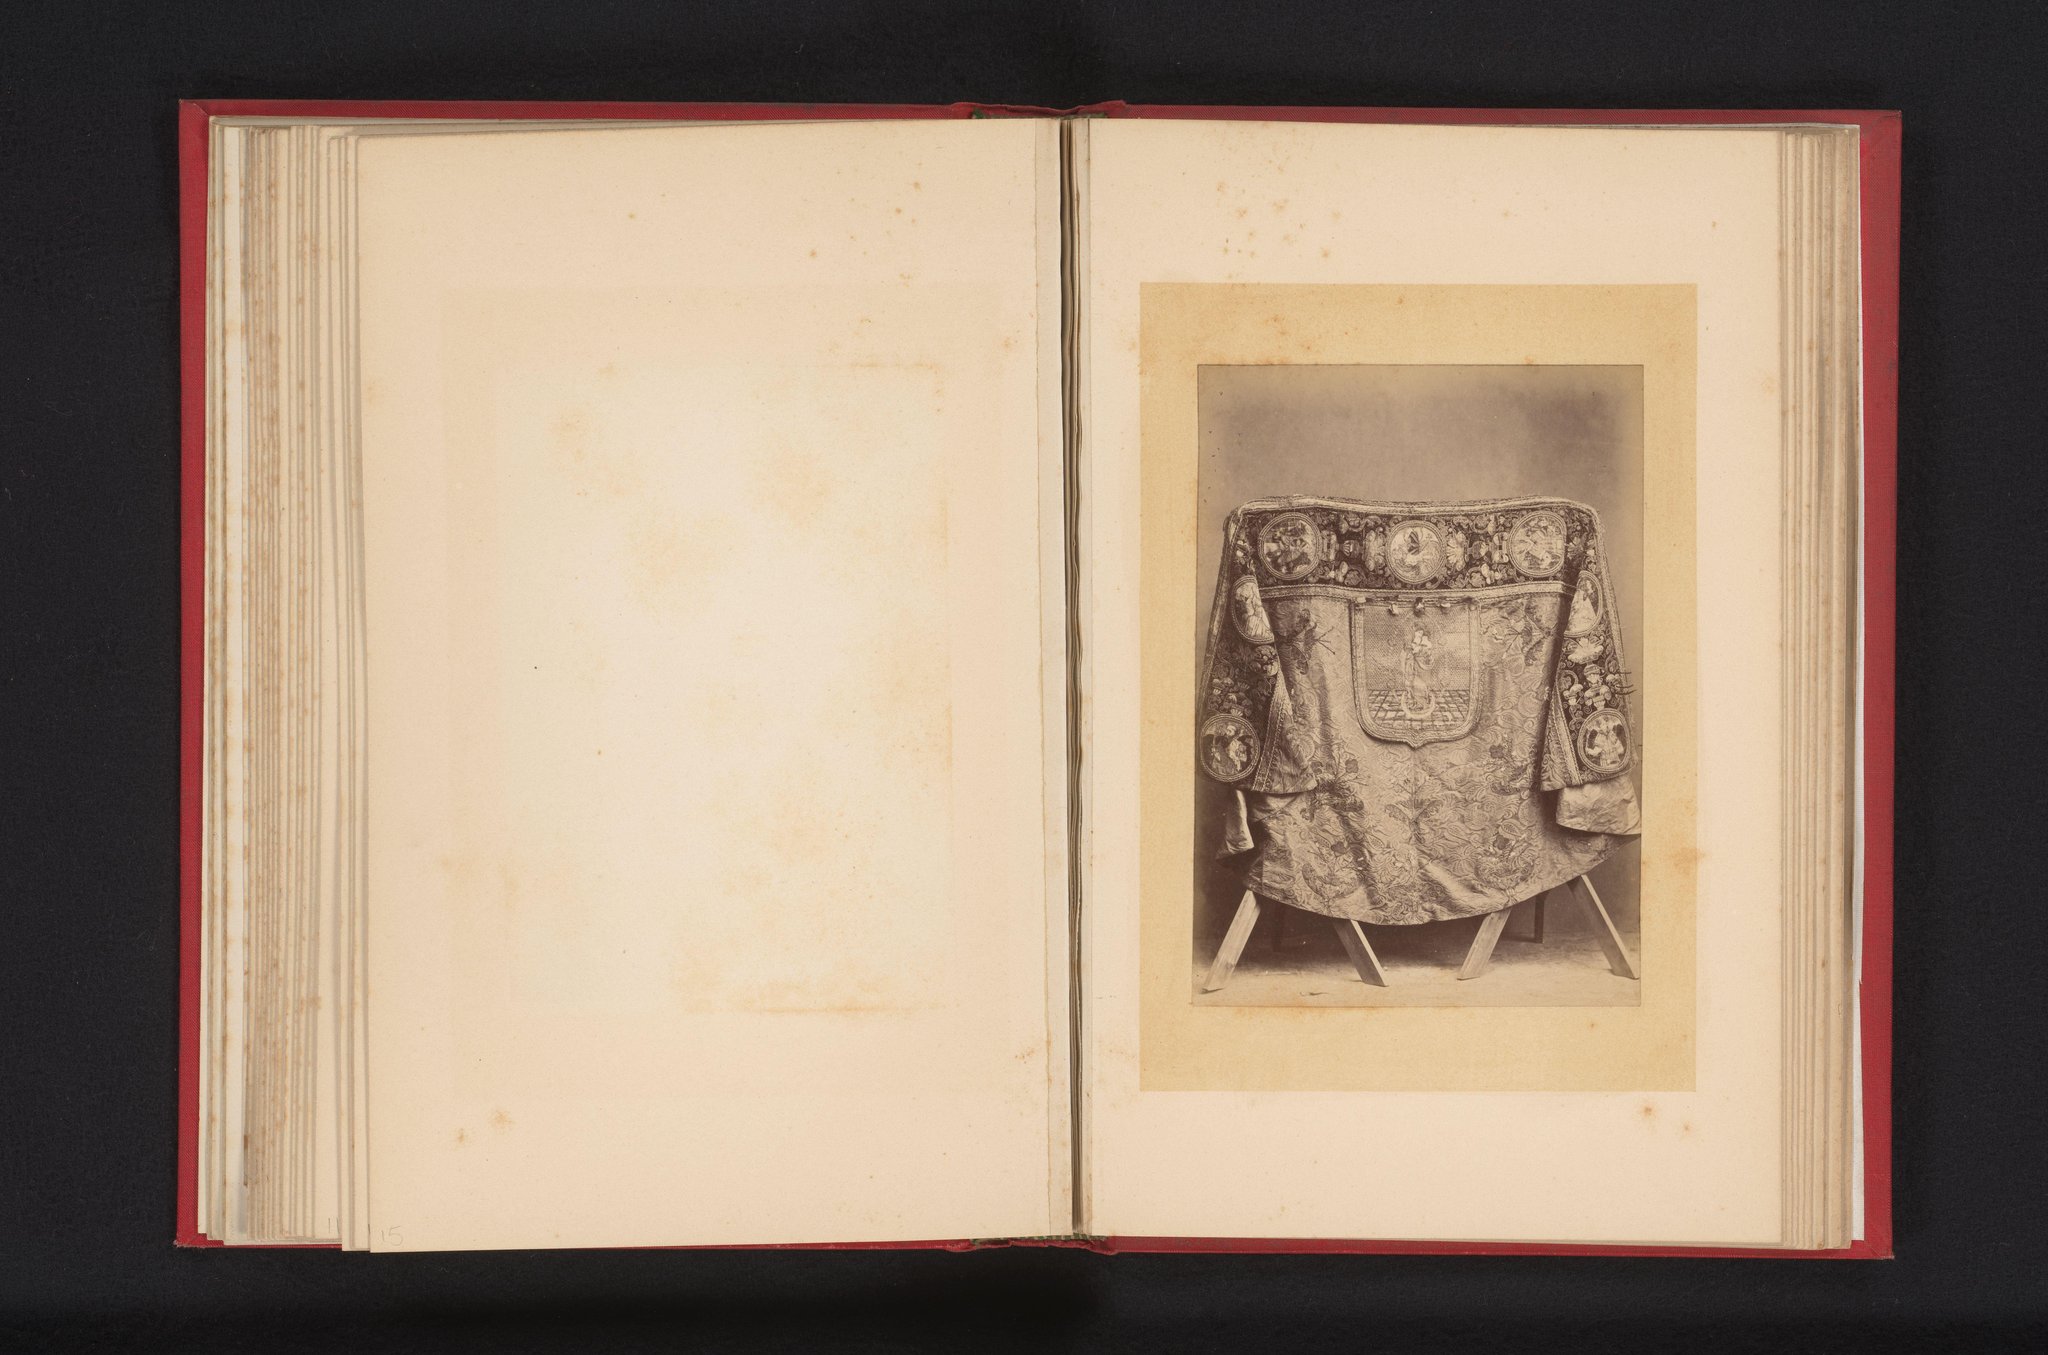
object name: photograph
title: Kazuifel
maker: Anonymous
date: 1873-1878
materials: photographic support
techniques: albumen print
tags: liturgical vestments, canonicals